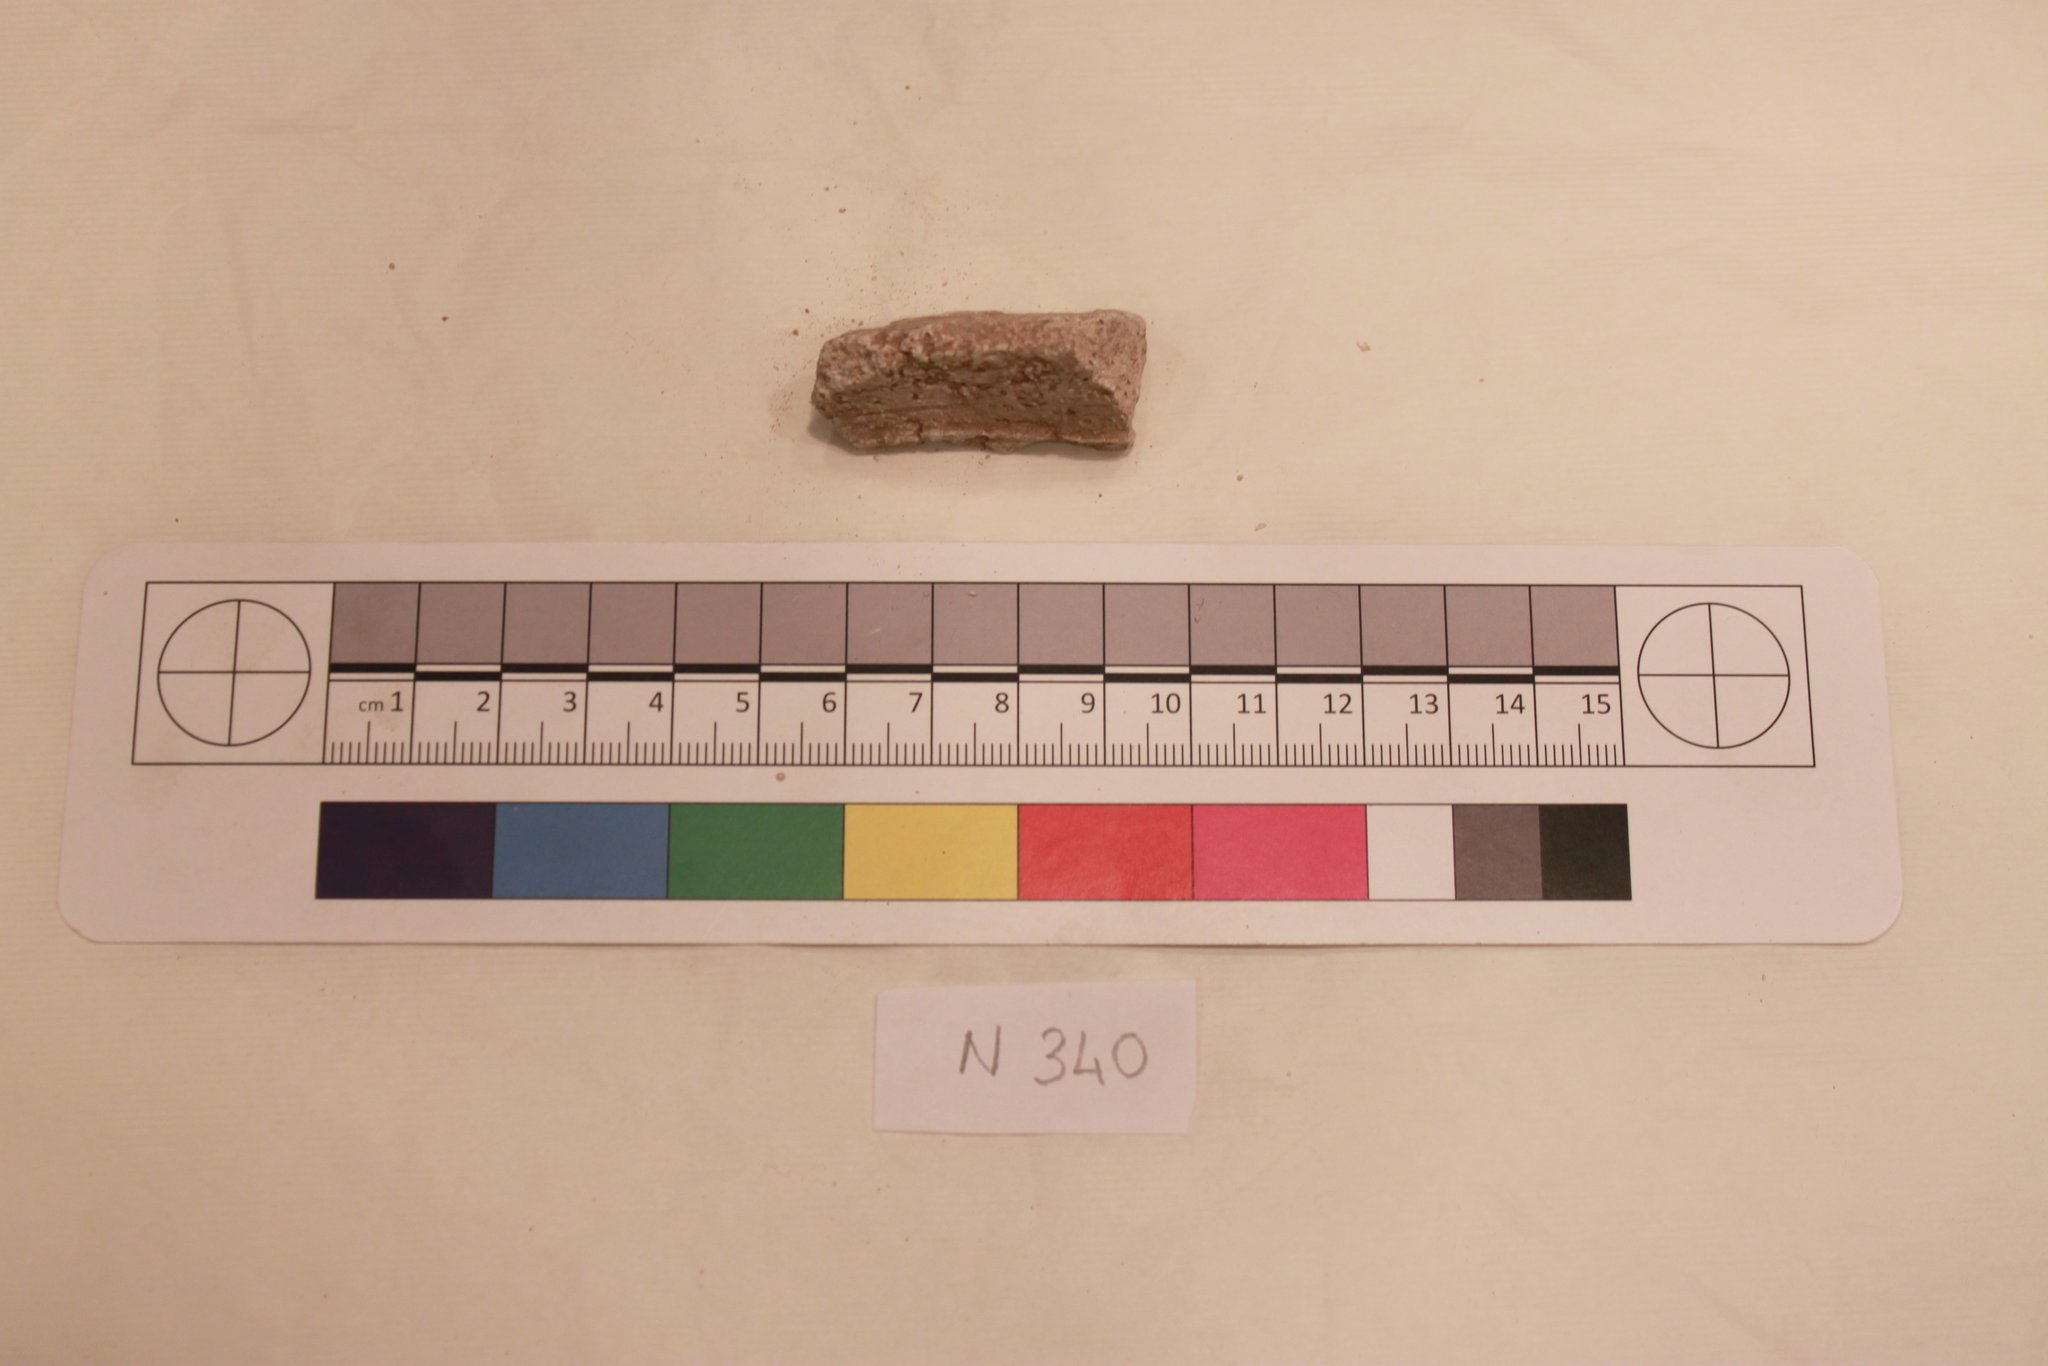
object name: fragment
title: Stucco Fragment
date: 701-1200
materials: plaster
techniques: carving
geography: iran